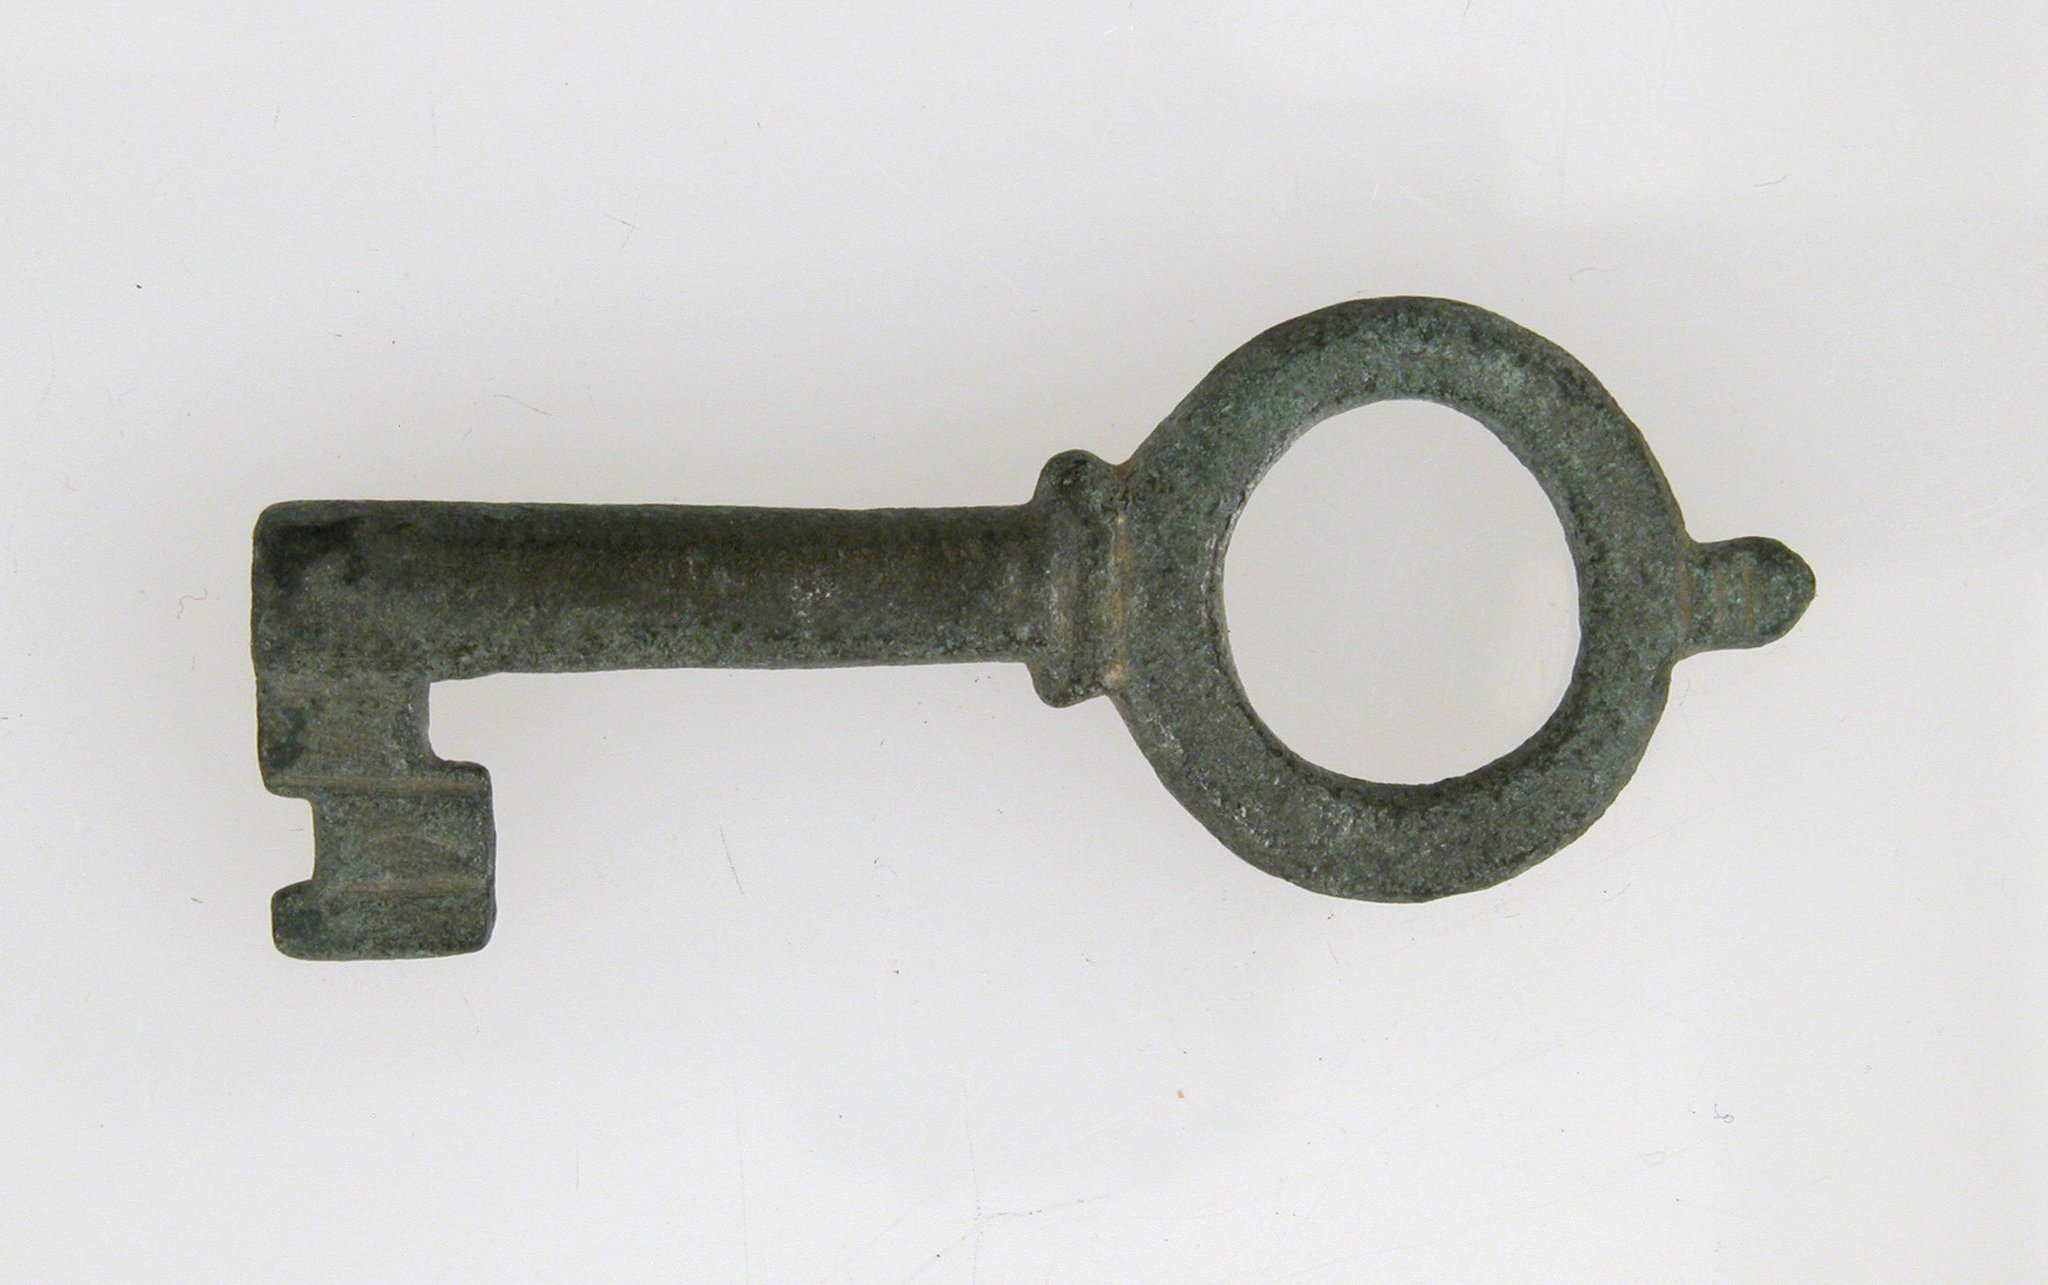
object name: key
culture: roman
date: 1-700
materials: copper alloy